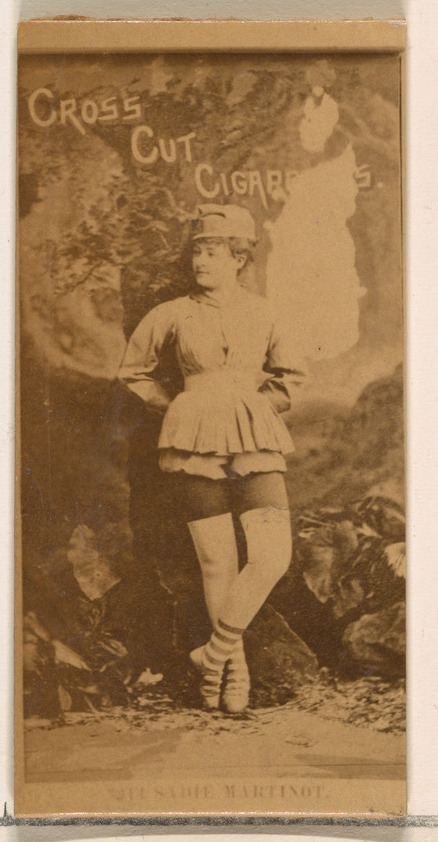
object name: print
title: Card Number 211, Miss Sadie Martinot, from the Actors and Actresses series (N145-2) issued by Duke Sons & Co. to promote Cross Cut Cigarettes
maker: w. duke, sons & co.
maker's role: publisher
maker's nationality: american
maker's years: 1870-1920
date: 1880-1889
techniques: albumen silver print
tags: portraits,women,actresses